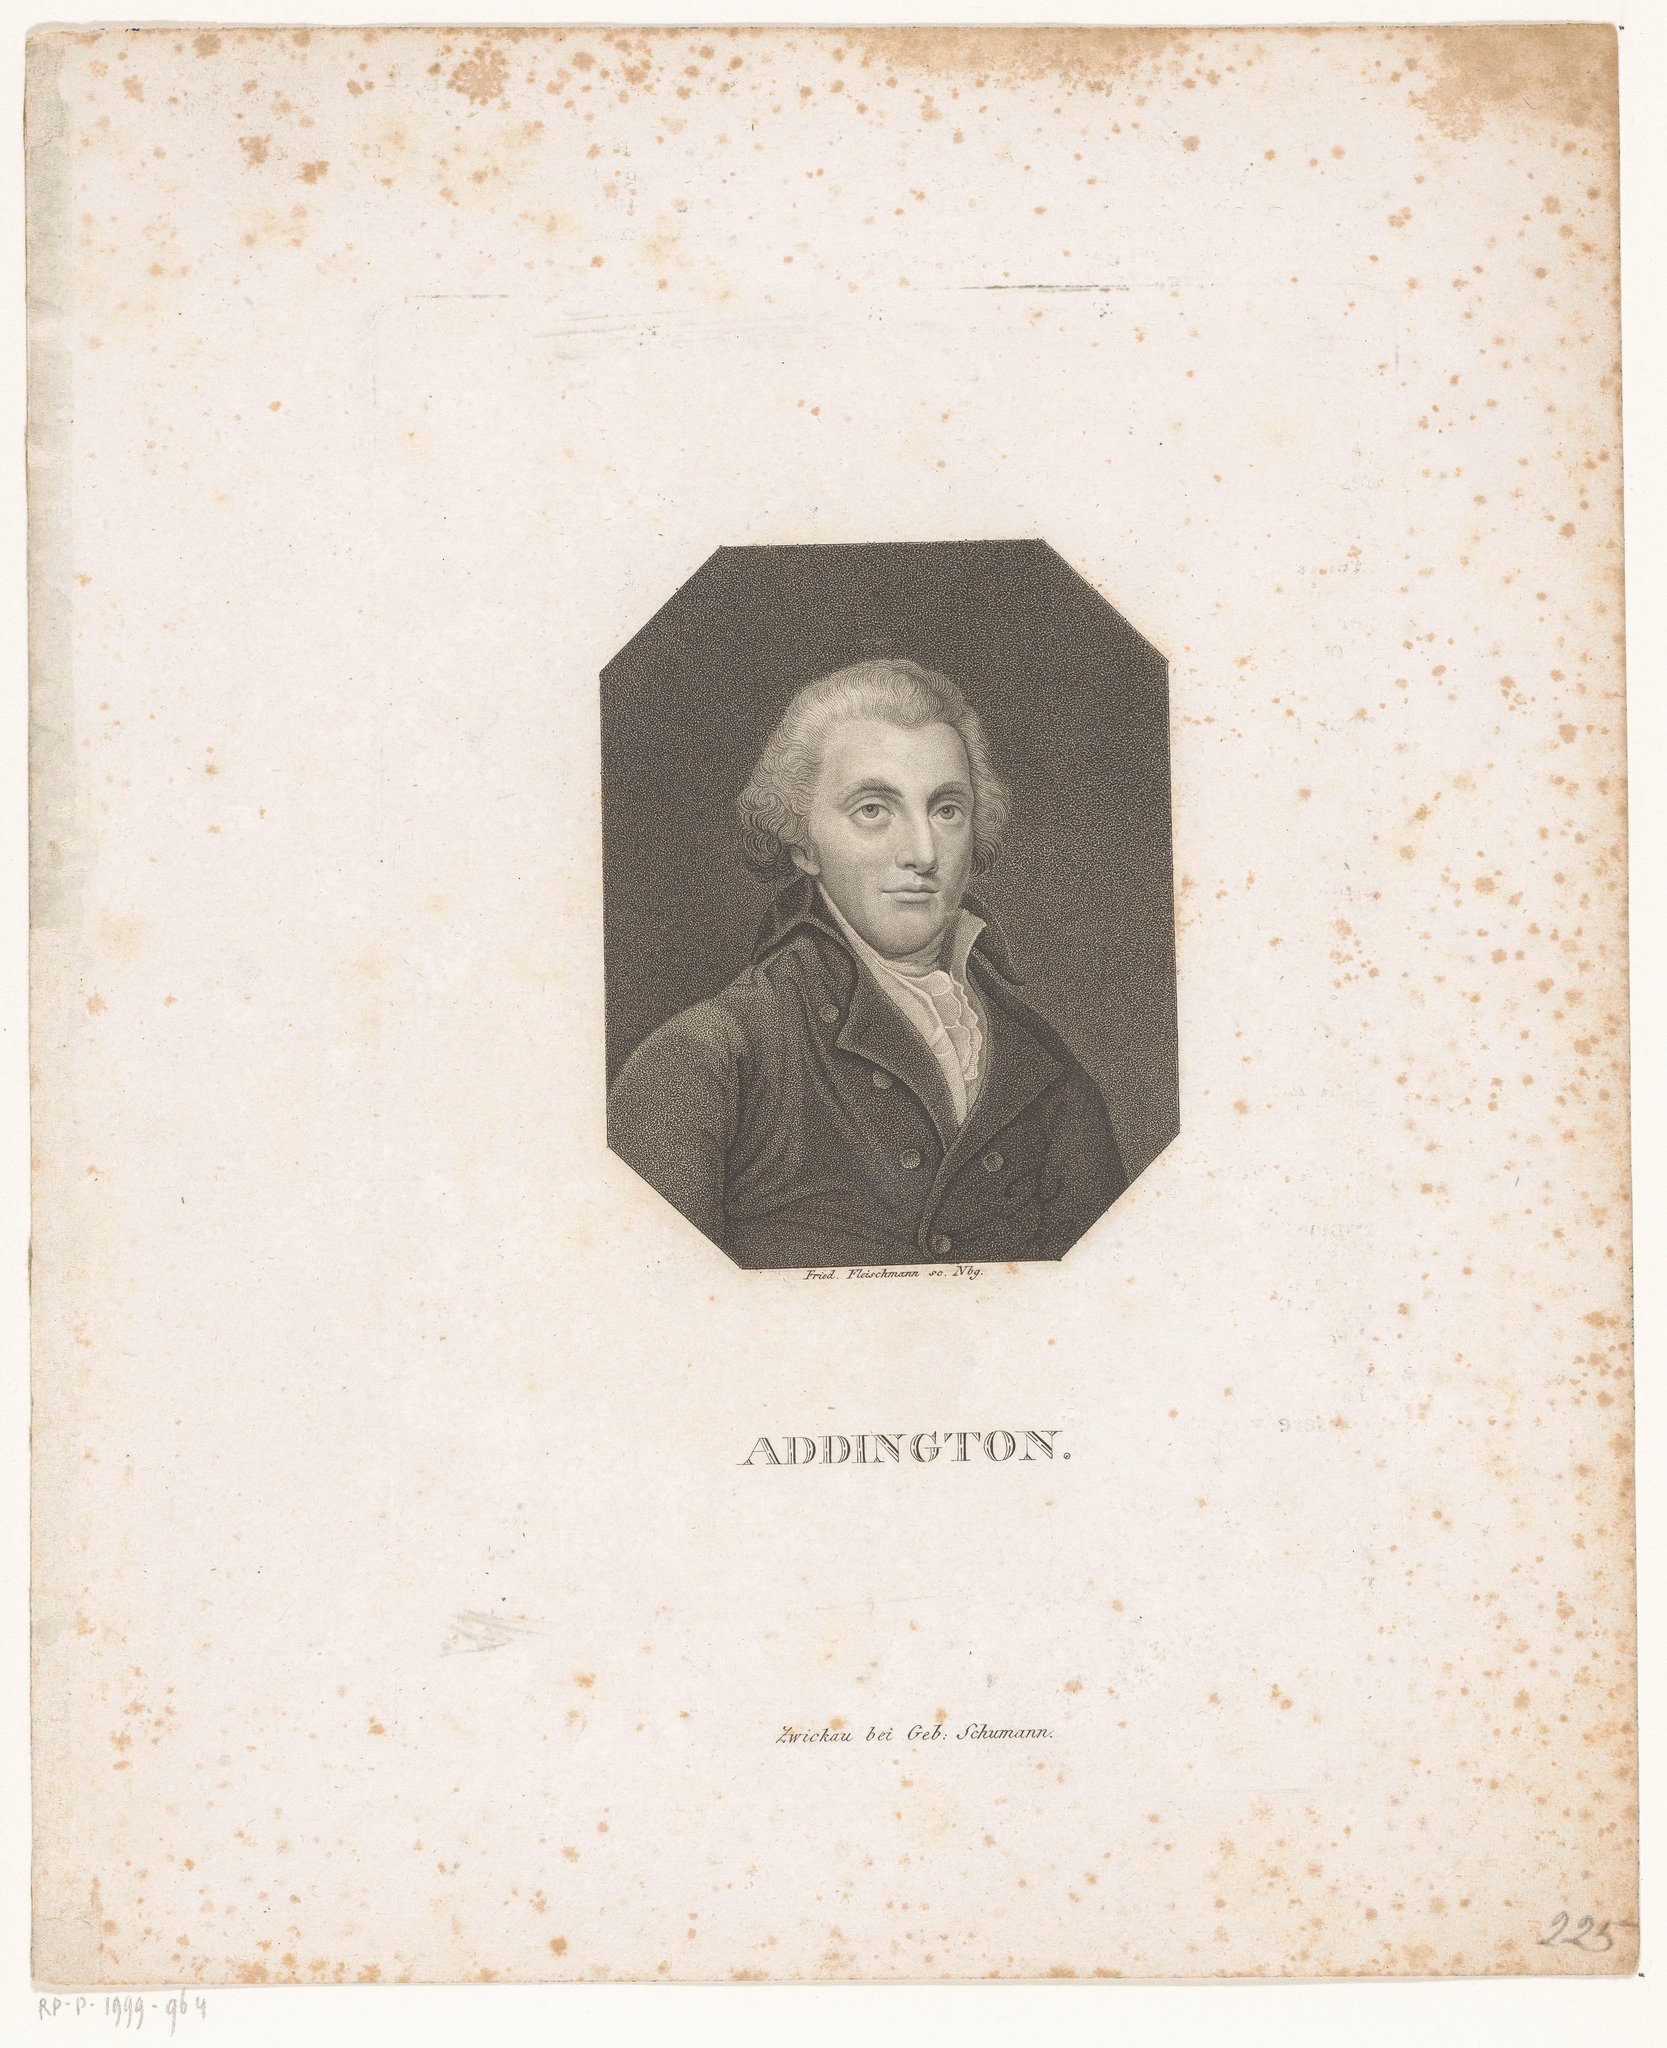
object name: print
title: Portretten van beroemde mensen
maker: friedrich fleischmann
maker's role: print maker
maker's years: 1791-1834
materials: paper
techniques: stippling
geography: zwickau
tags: london, historical persons, politician, e.g. party leader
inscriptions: collector's mark: Lugt 2760, collector's mark: Lugt 2228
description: Prent afkomstig uit: 'Bildnisse der berühmtesten Menschen aller Völker und Zeiten' van de gebroeders Schumann, uitgegeven in 1818-1832 te Zwickau.